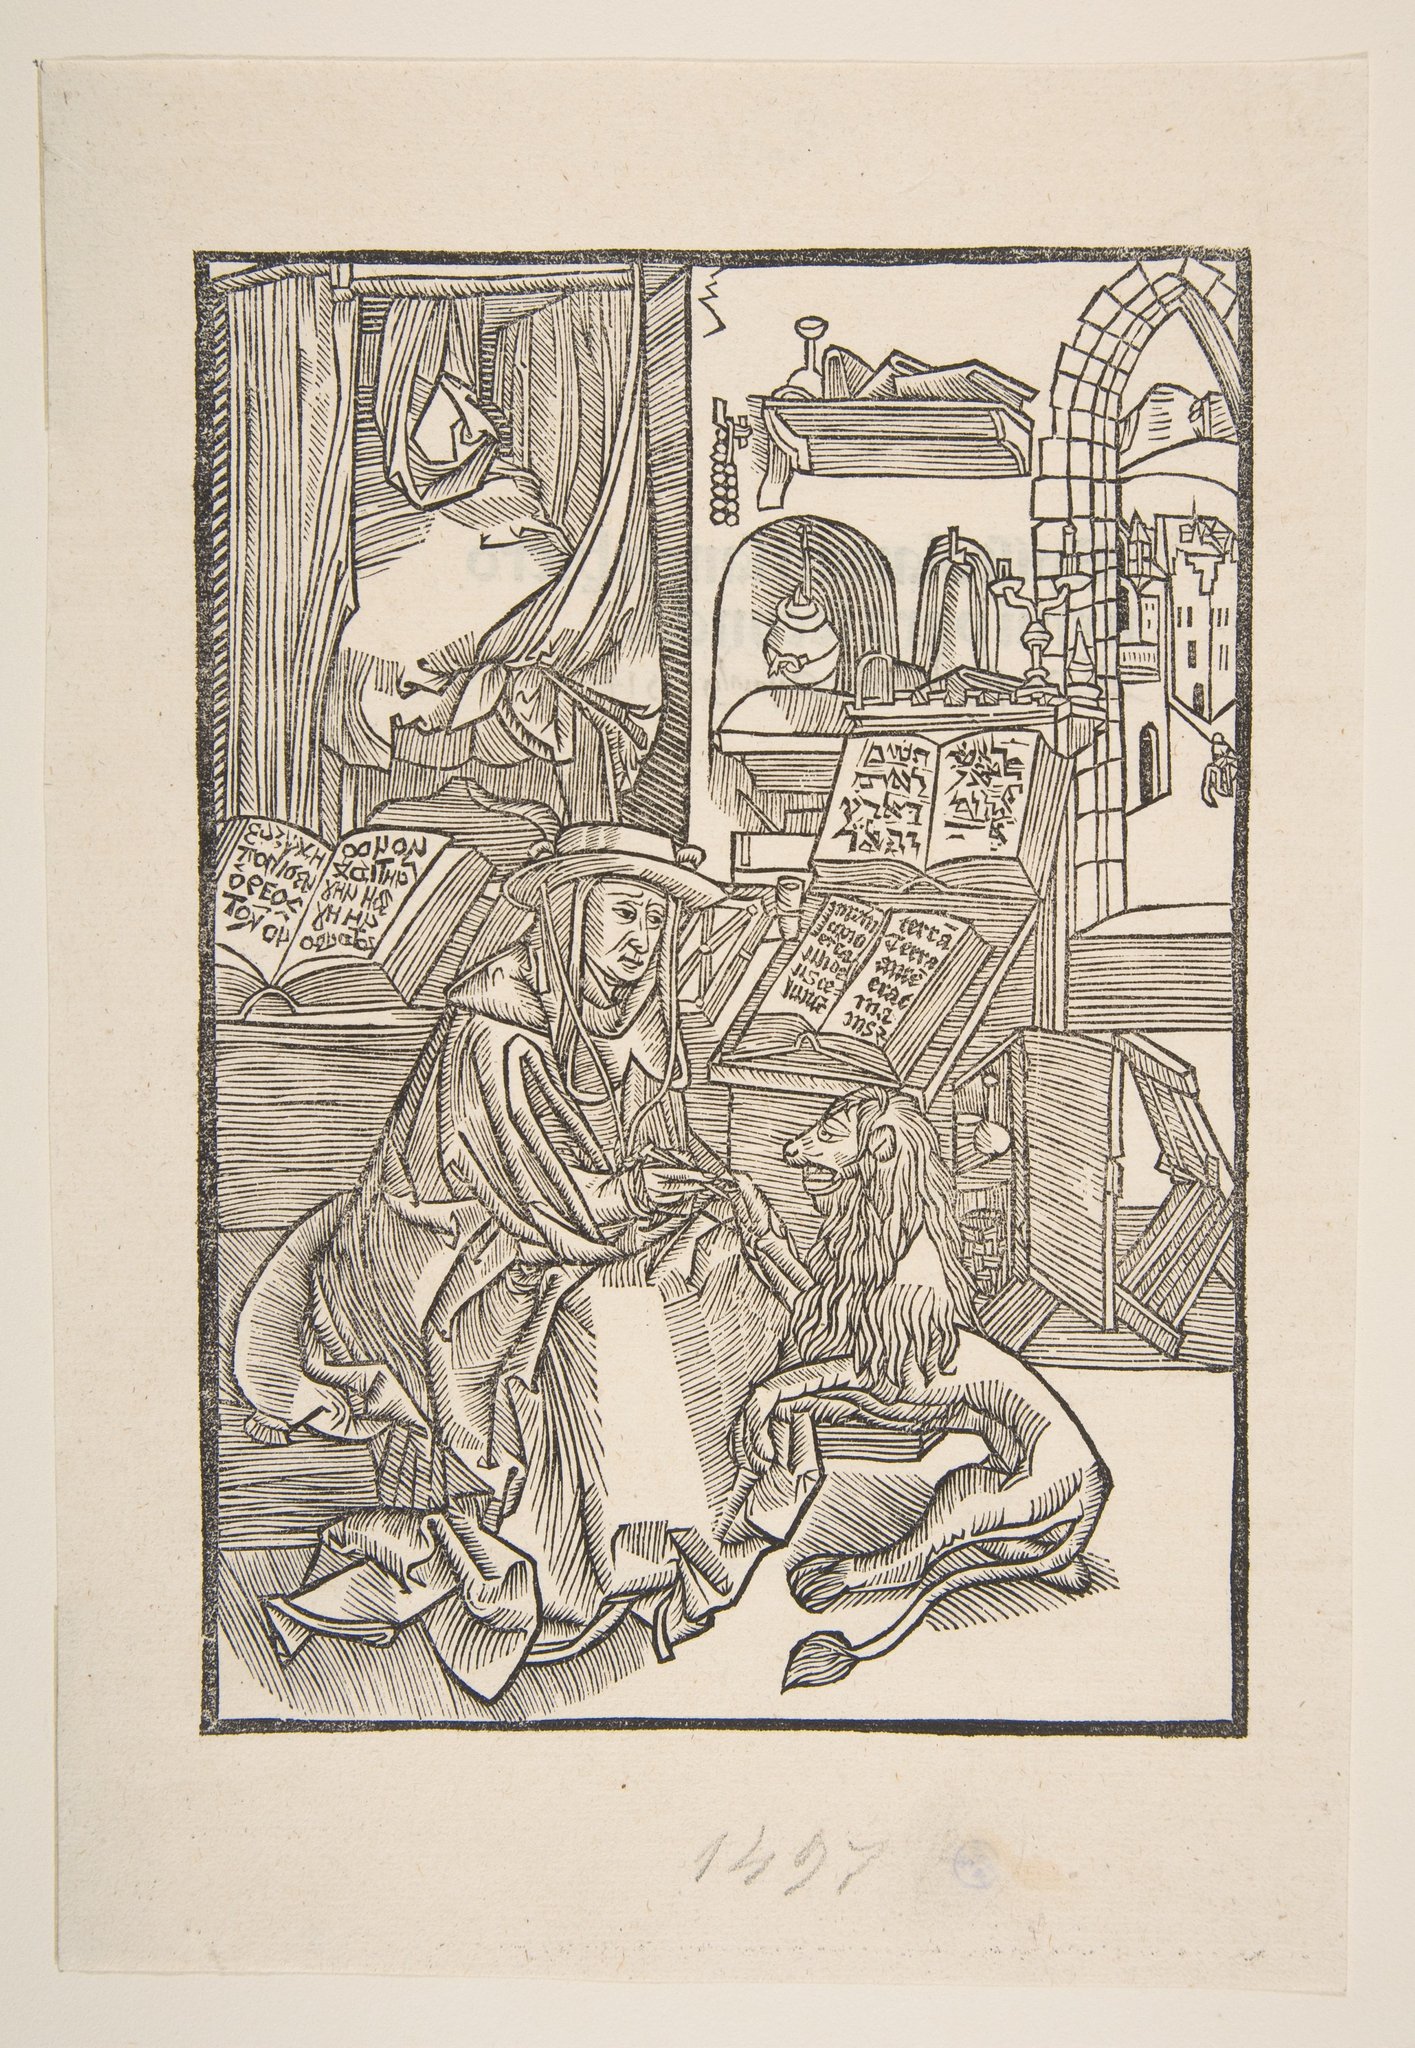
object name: print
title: Saint Jerome exctracting a Thorn from the Lion's Foot (copy)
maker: albrecht dürer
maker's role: artist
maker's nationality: german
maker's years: 1471-1528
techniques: woodcut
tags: books,lions,saint jerome